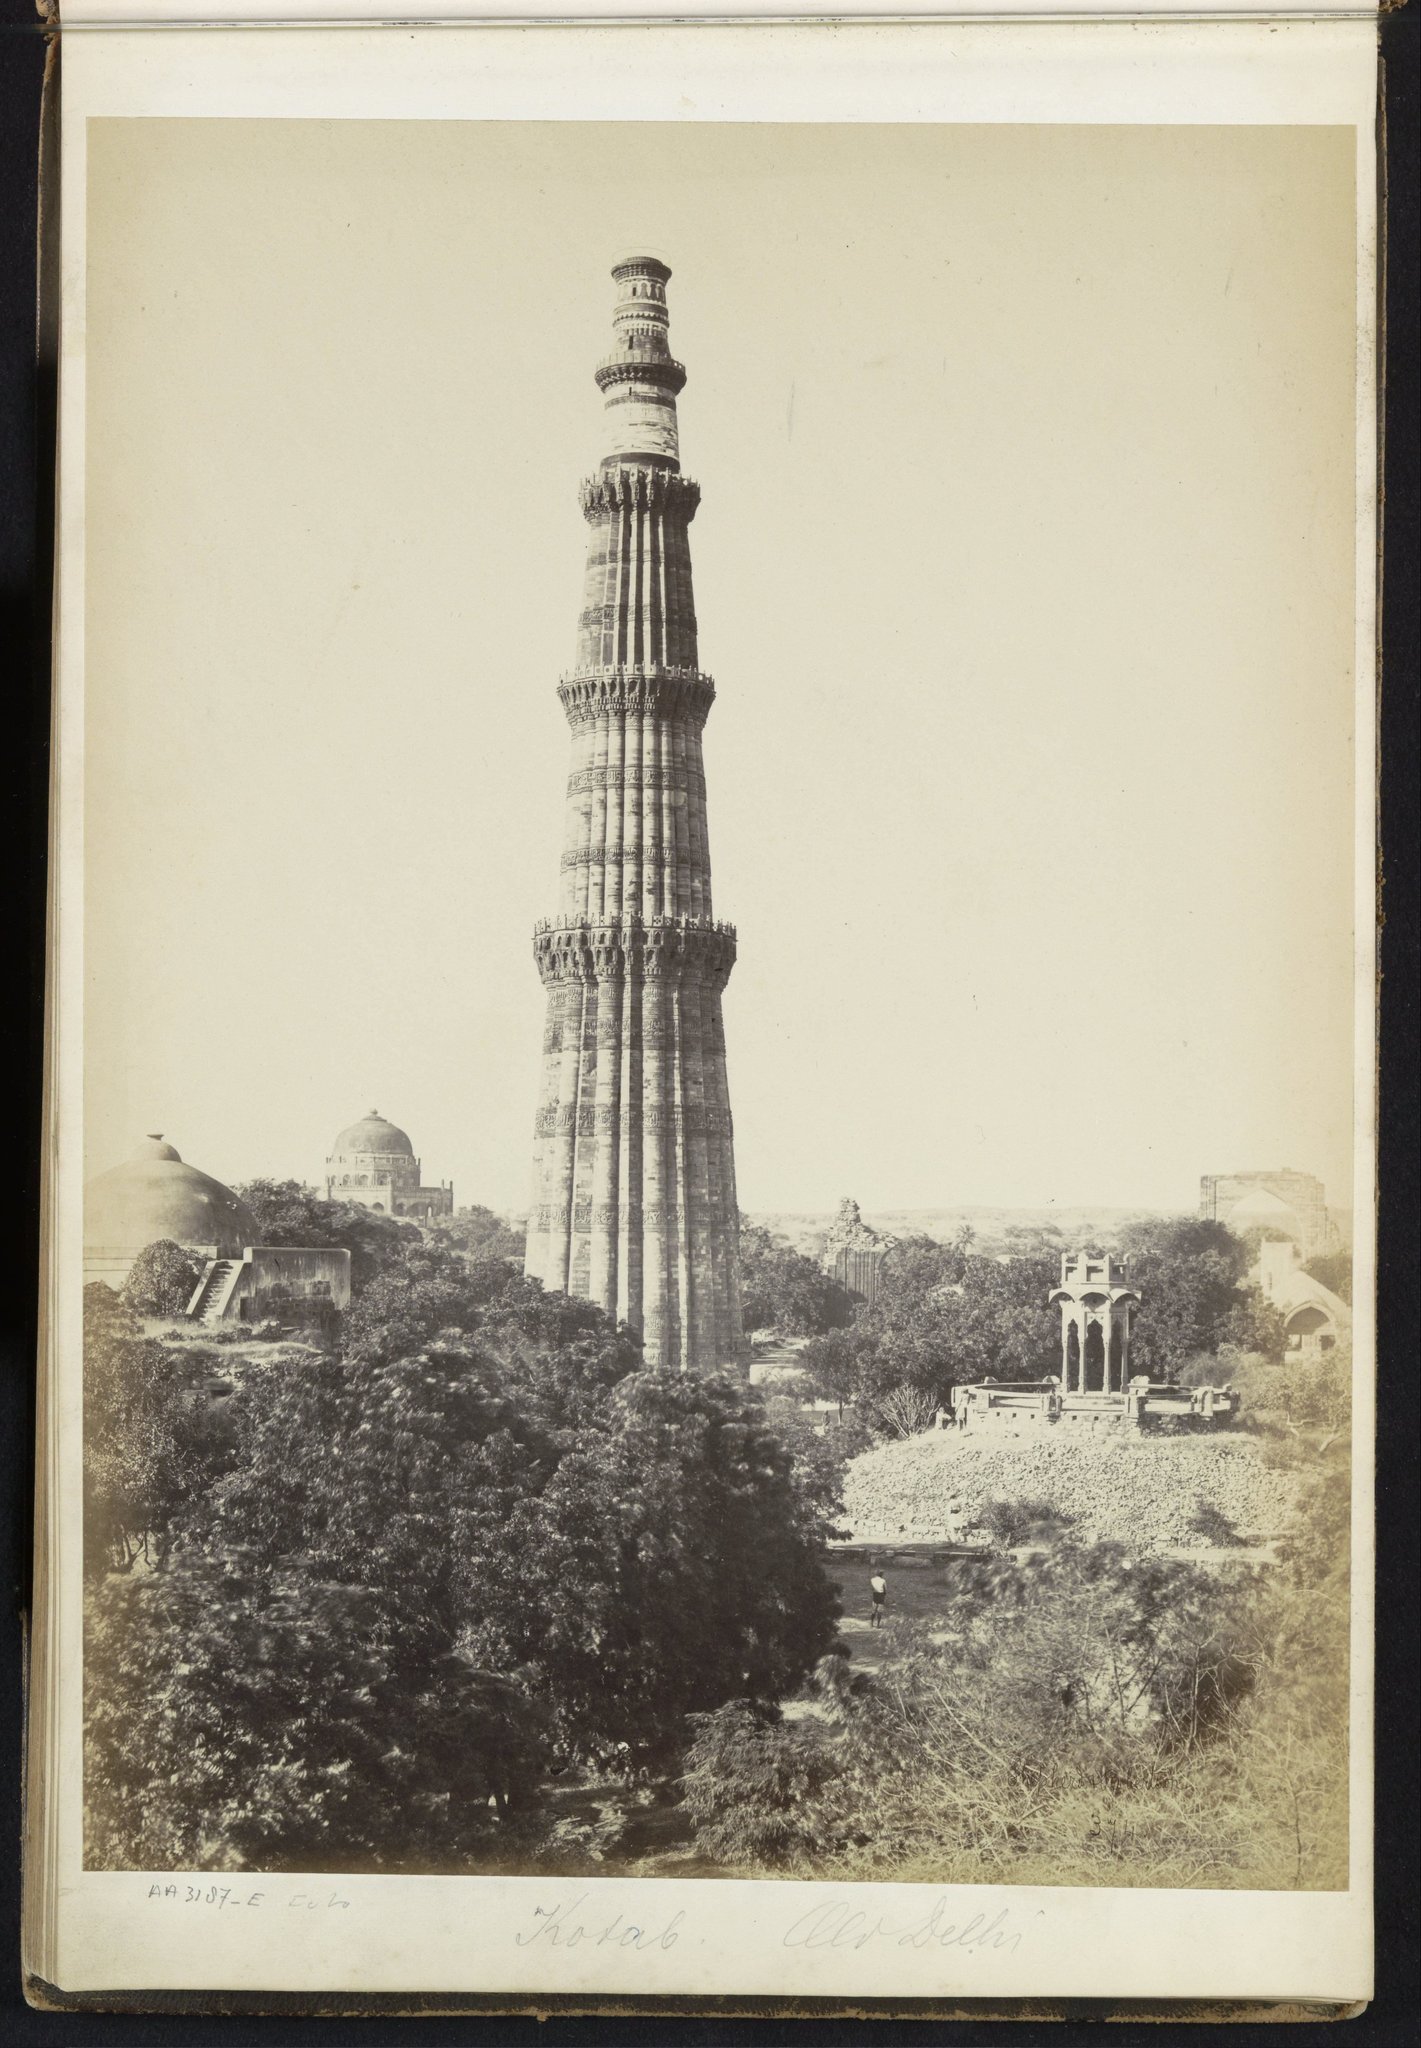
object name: photograph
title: Exterior of the Qutb Minar in Delhi, India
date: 1862-1863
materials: photographic support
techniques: albumen print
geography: delhi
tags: temple, shrine ~ islam, mohammedanism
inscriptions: title: ‘Kotab. Old Delhi’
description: Onderdeel van Reisalbum met opnames van bezienswaardigheden in India, Duitsland, Zwitserland en Frankrijk.